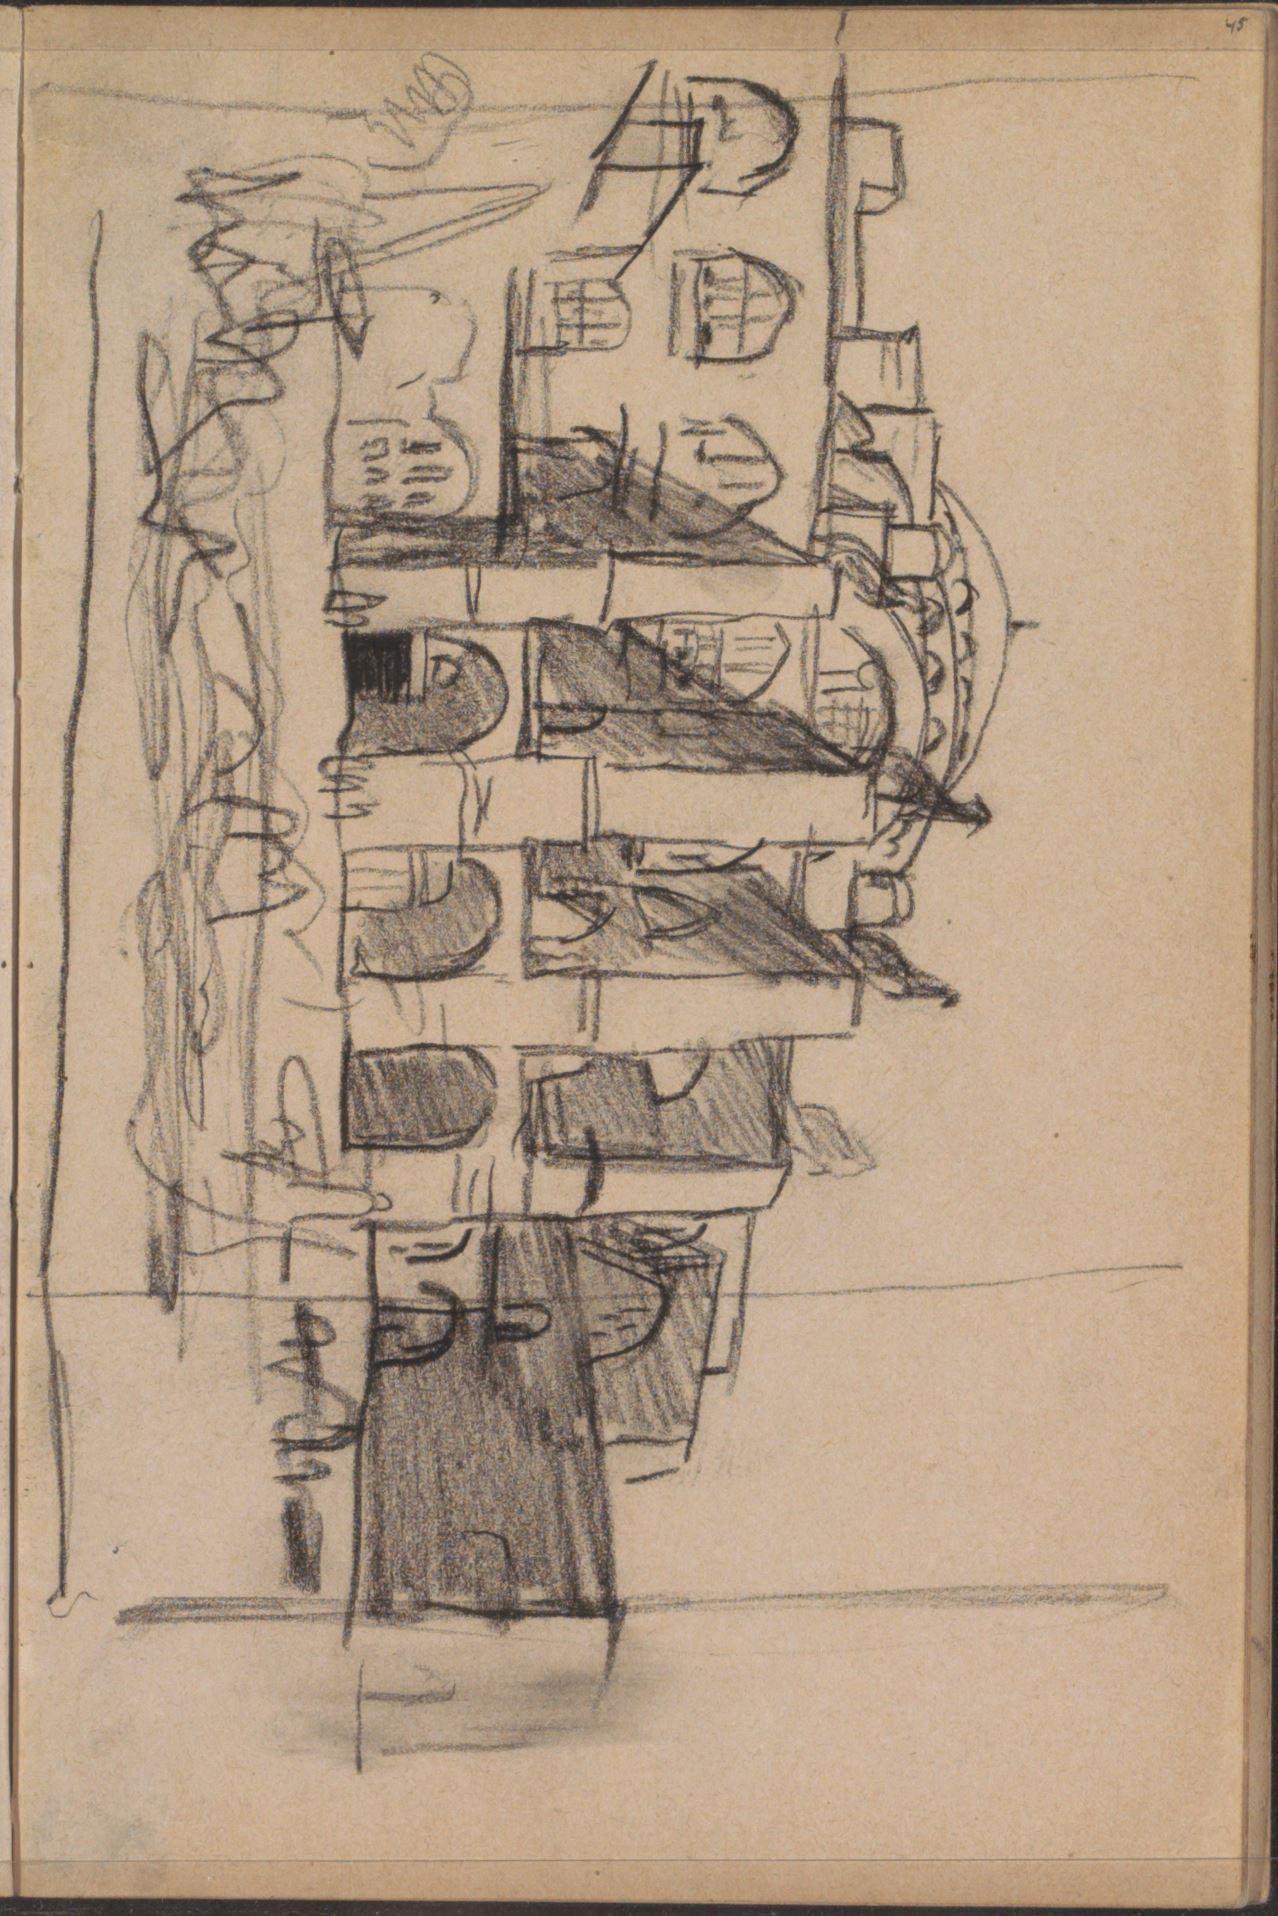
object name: sketchbook leaf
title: Boogconstructie aan de achterzijde van een gebouw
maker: marius bauer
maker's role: draughtsman, print maker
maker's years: 1867-1932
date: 1896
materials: chalk, paper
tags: arch, archivolt ~ architecture, architecture, dome ~ architecture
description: Het gebouw heeft een koepeldak. Pagina 45 uit een schetsboek met 45 bladen.